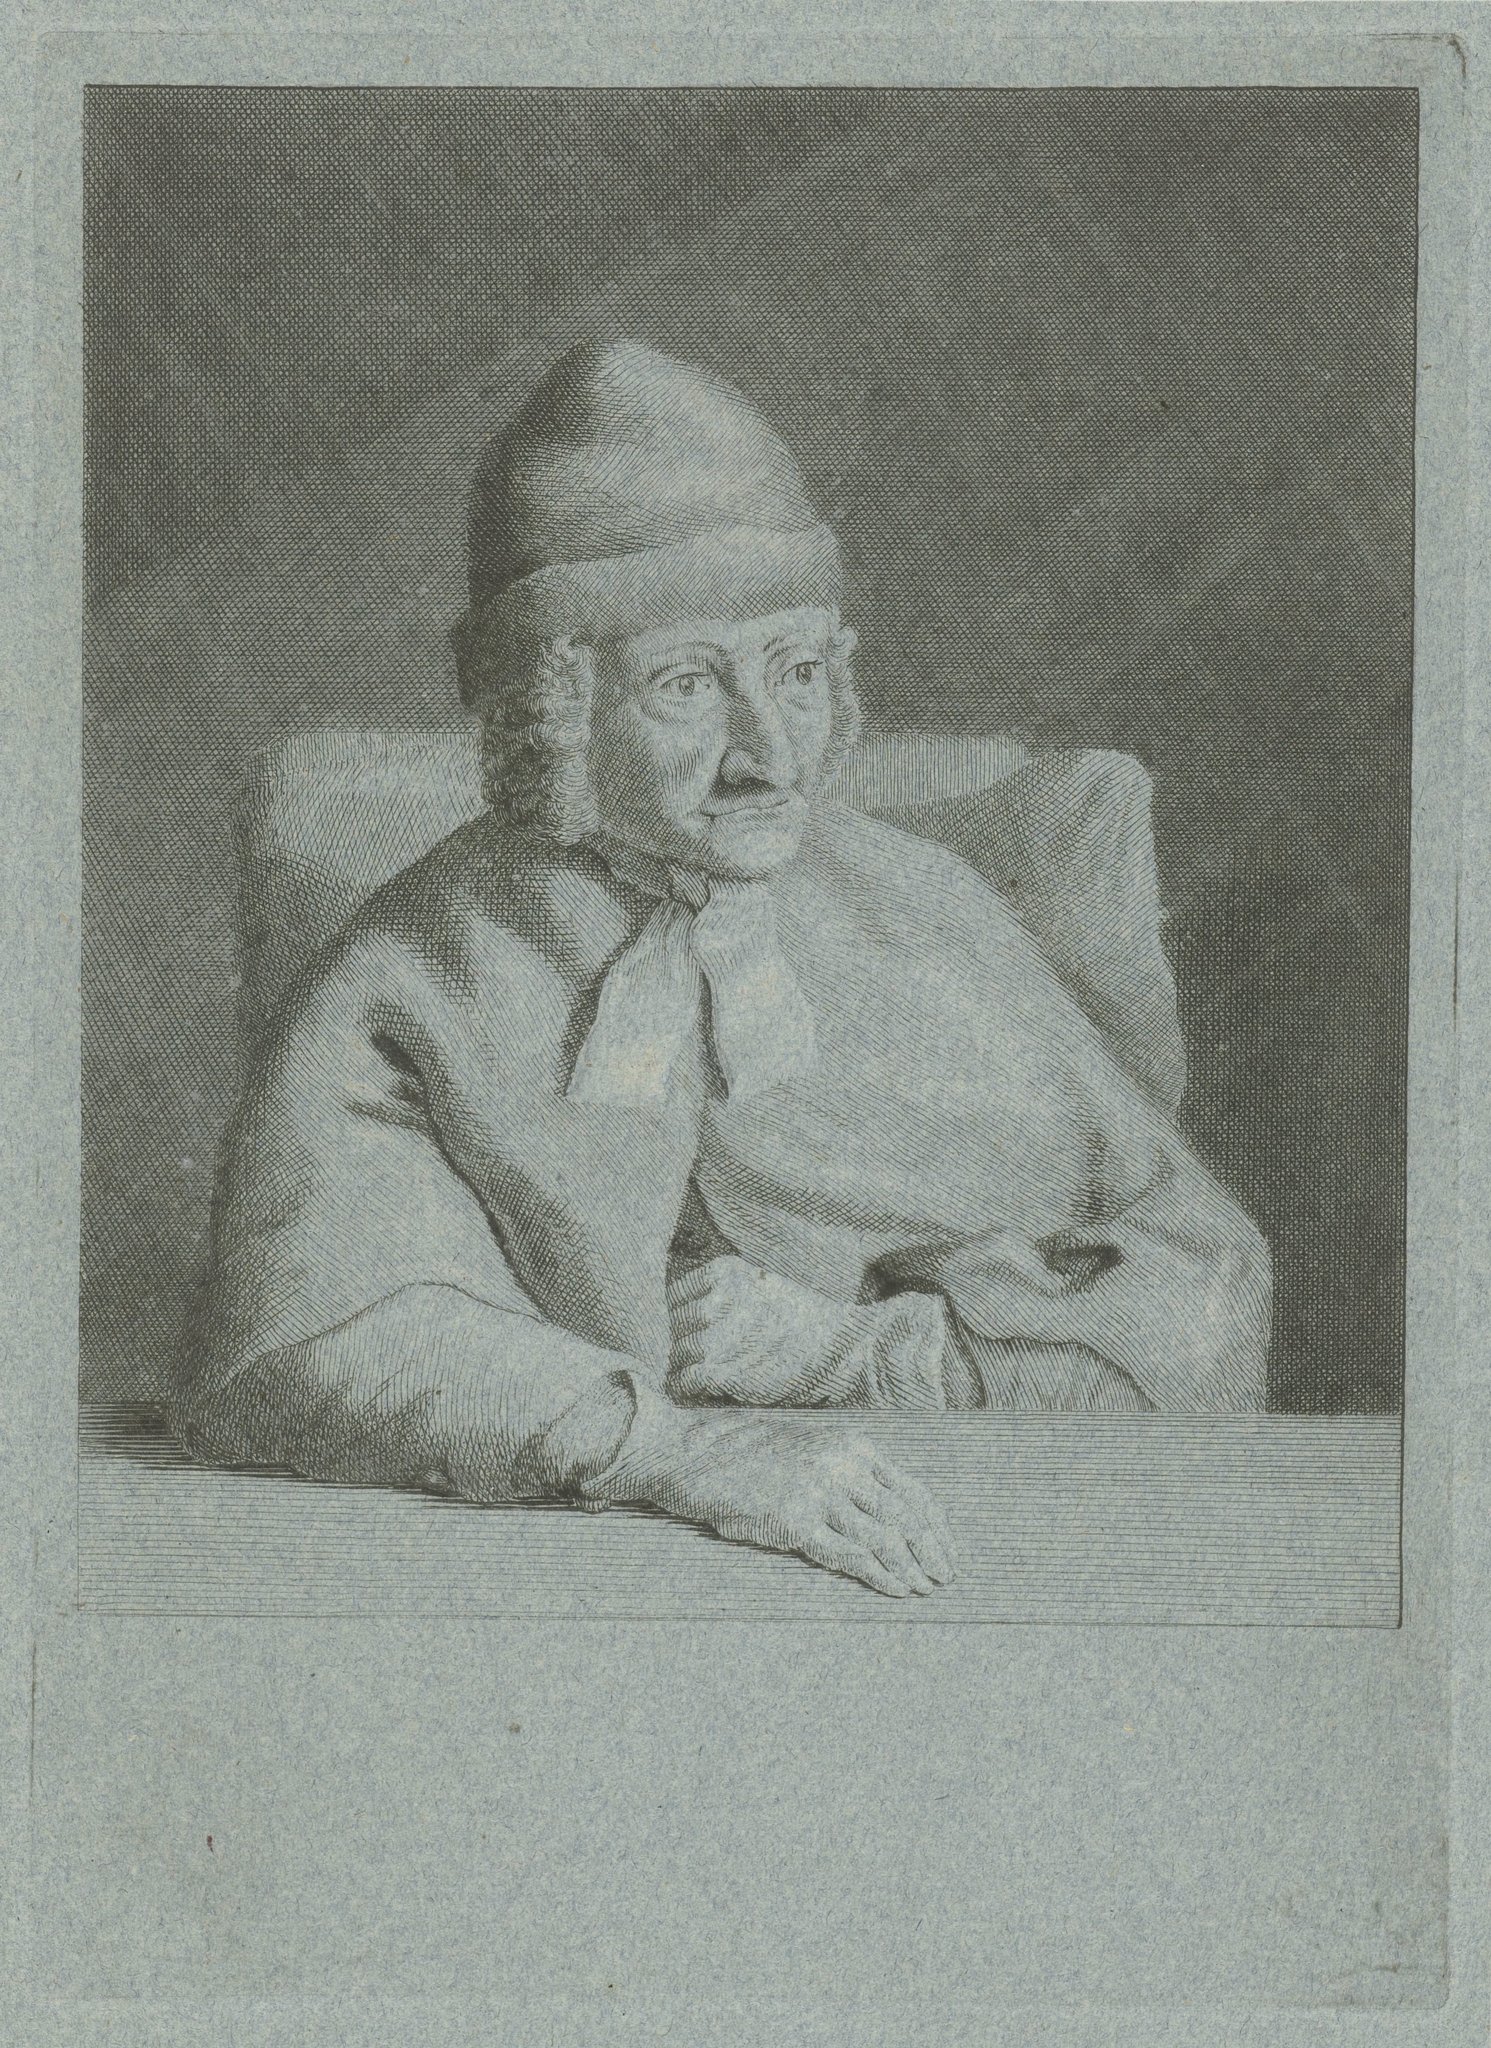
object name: print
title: Portret van Jan Christiaansz van der Winde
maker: cornelis van noorde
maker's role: draughtsman, print maker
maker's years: 1731-1795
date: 1764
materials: paper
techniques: engraving, etching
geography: haarlem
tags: jan christiaansz van der winde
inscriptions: collector's mark: Lugt 2228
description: Portret van Jan Christiaansz van der Winde op 100-jarige leeftijd.